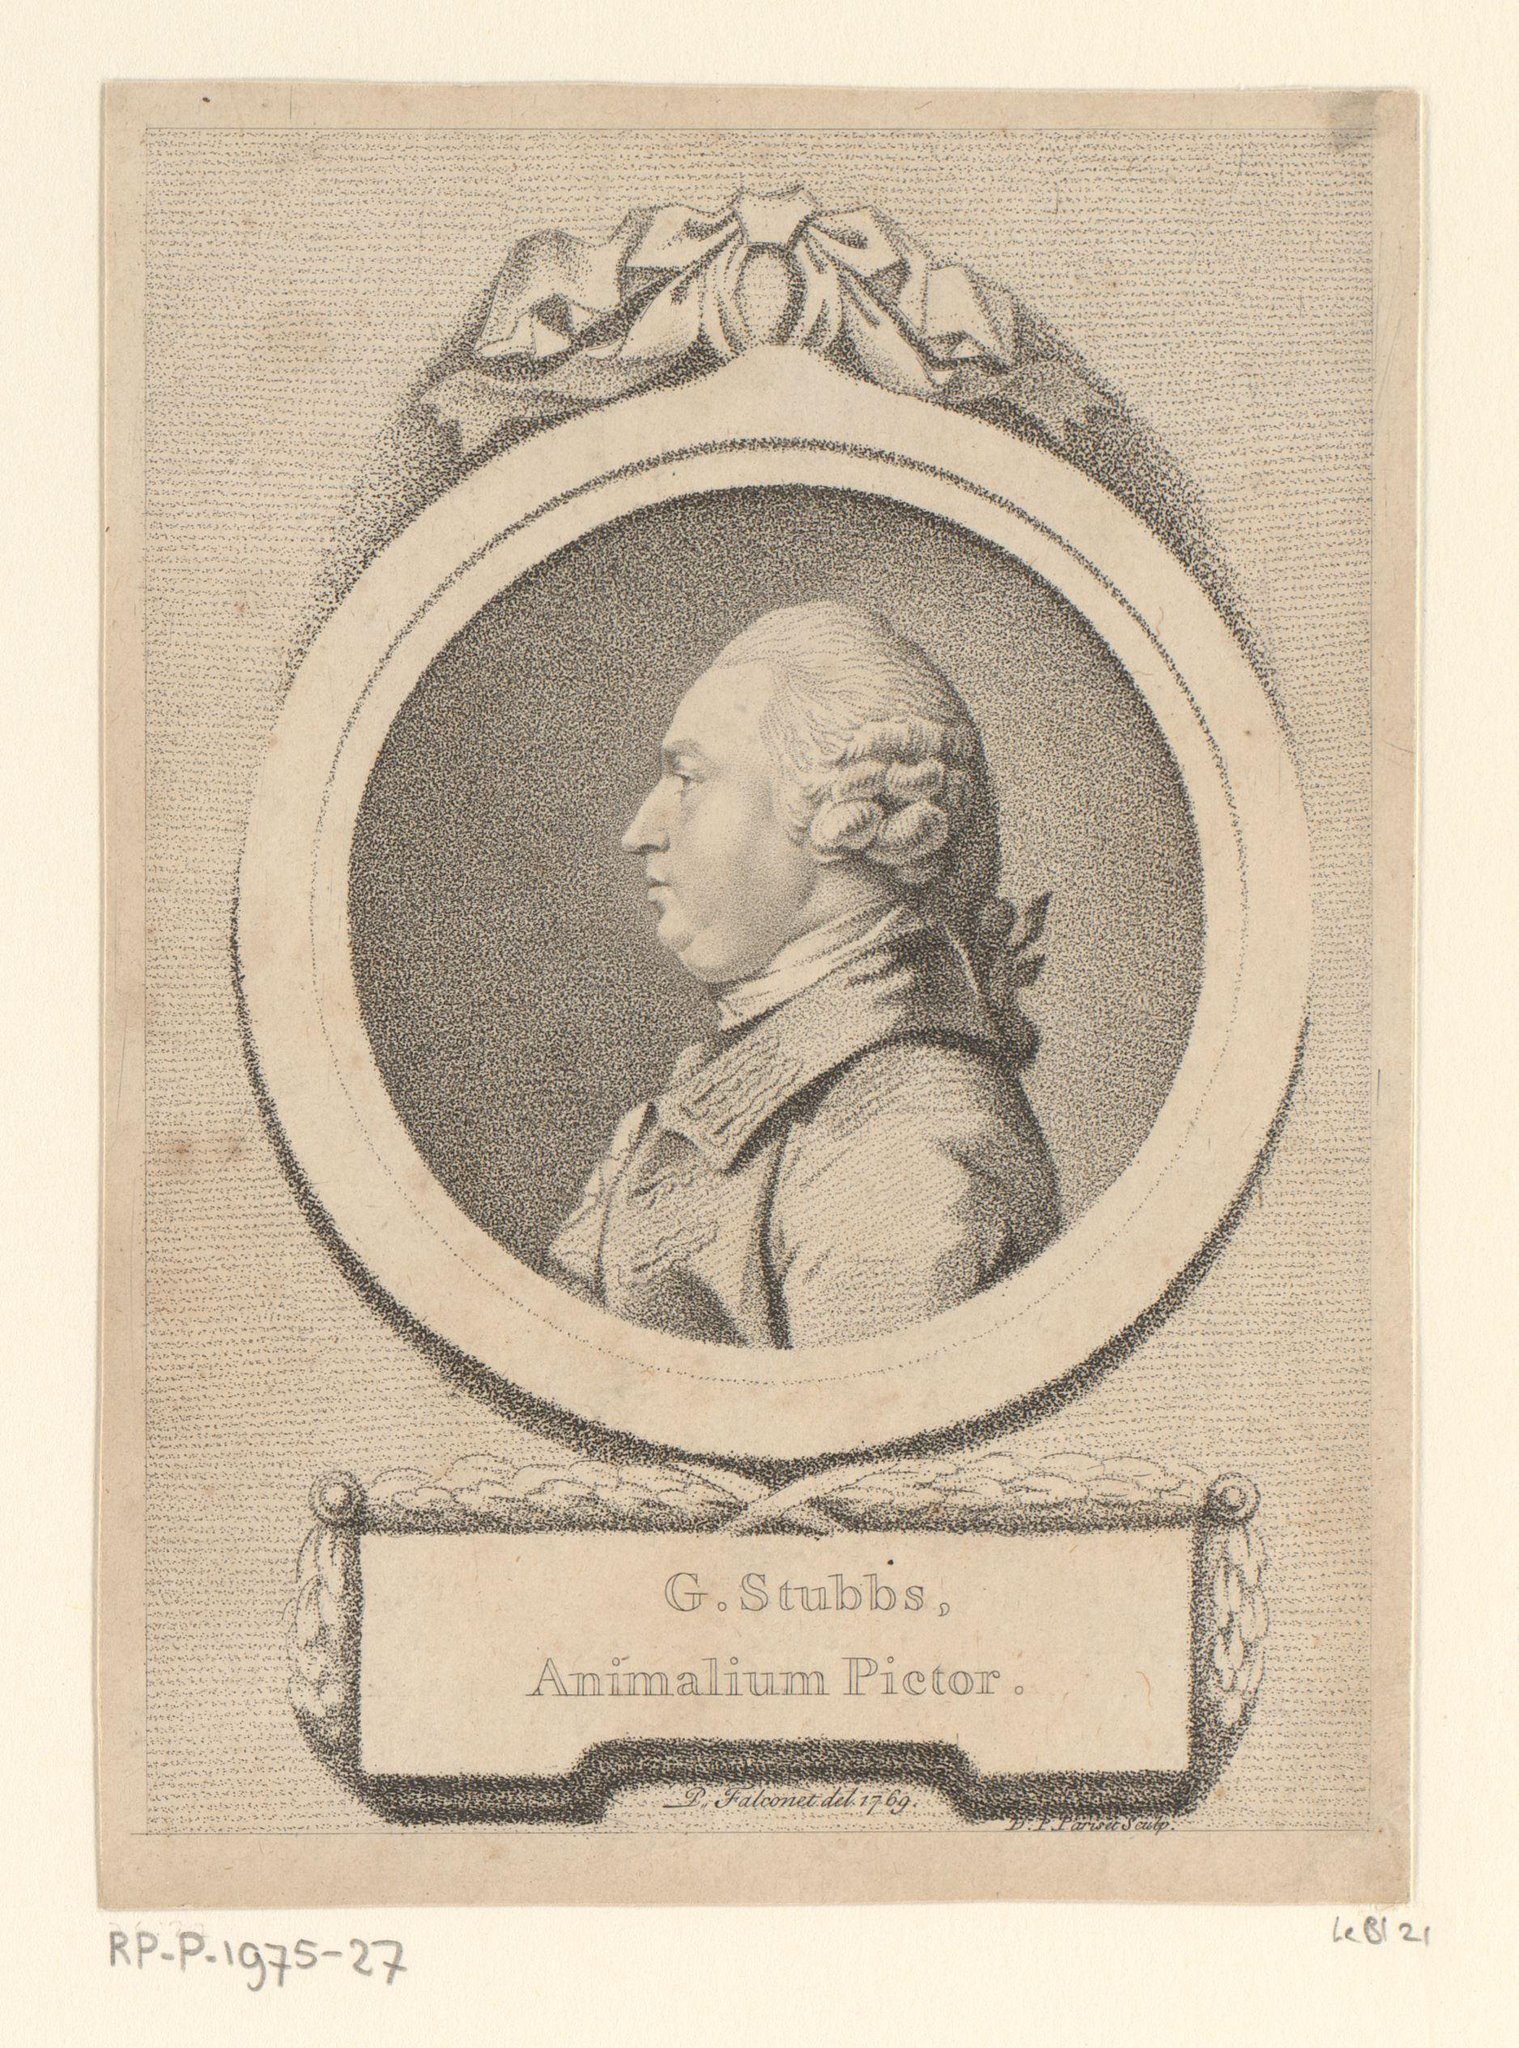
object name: print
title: Portret van George Stubbs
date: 1769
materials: paper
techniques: etching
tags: liverpool, london, painter, print maker, george stubbs, historical persons, portrait, self-portrait of painter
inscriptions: collector's mark: Lugt 2228, collector's mark: Lugt 2760